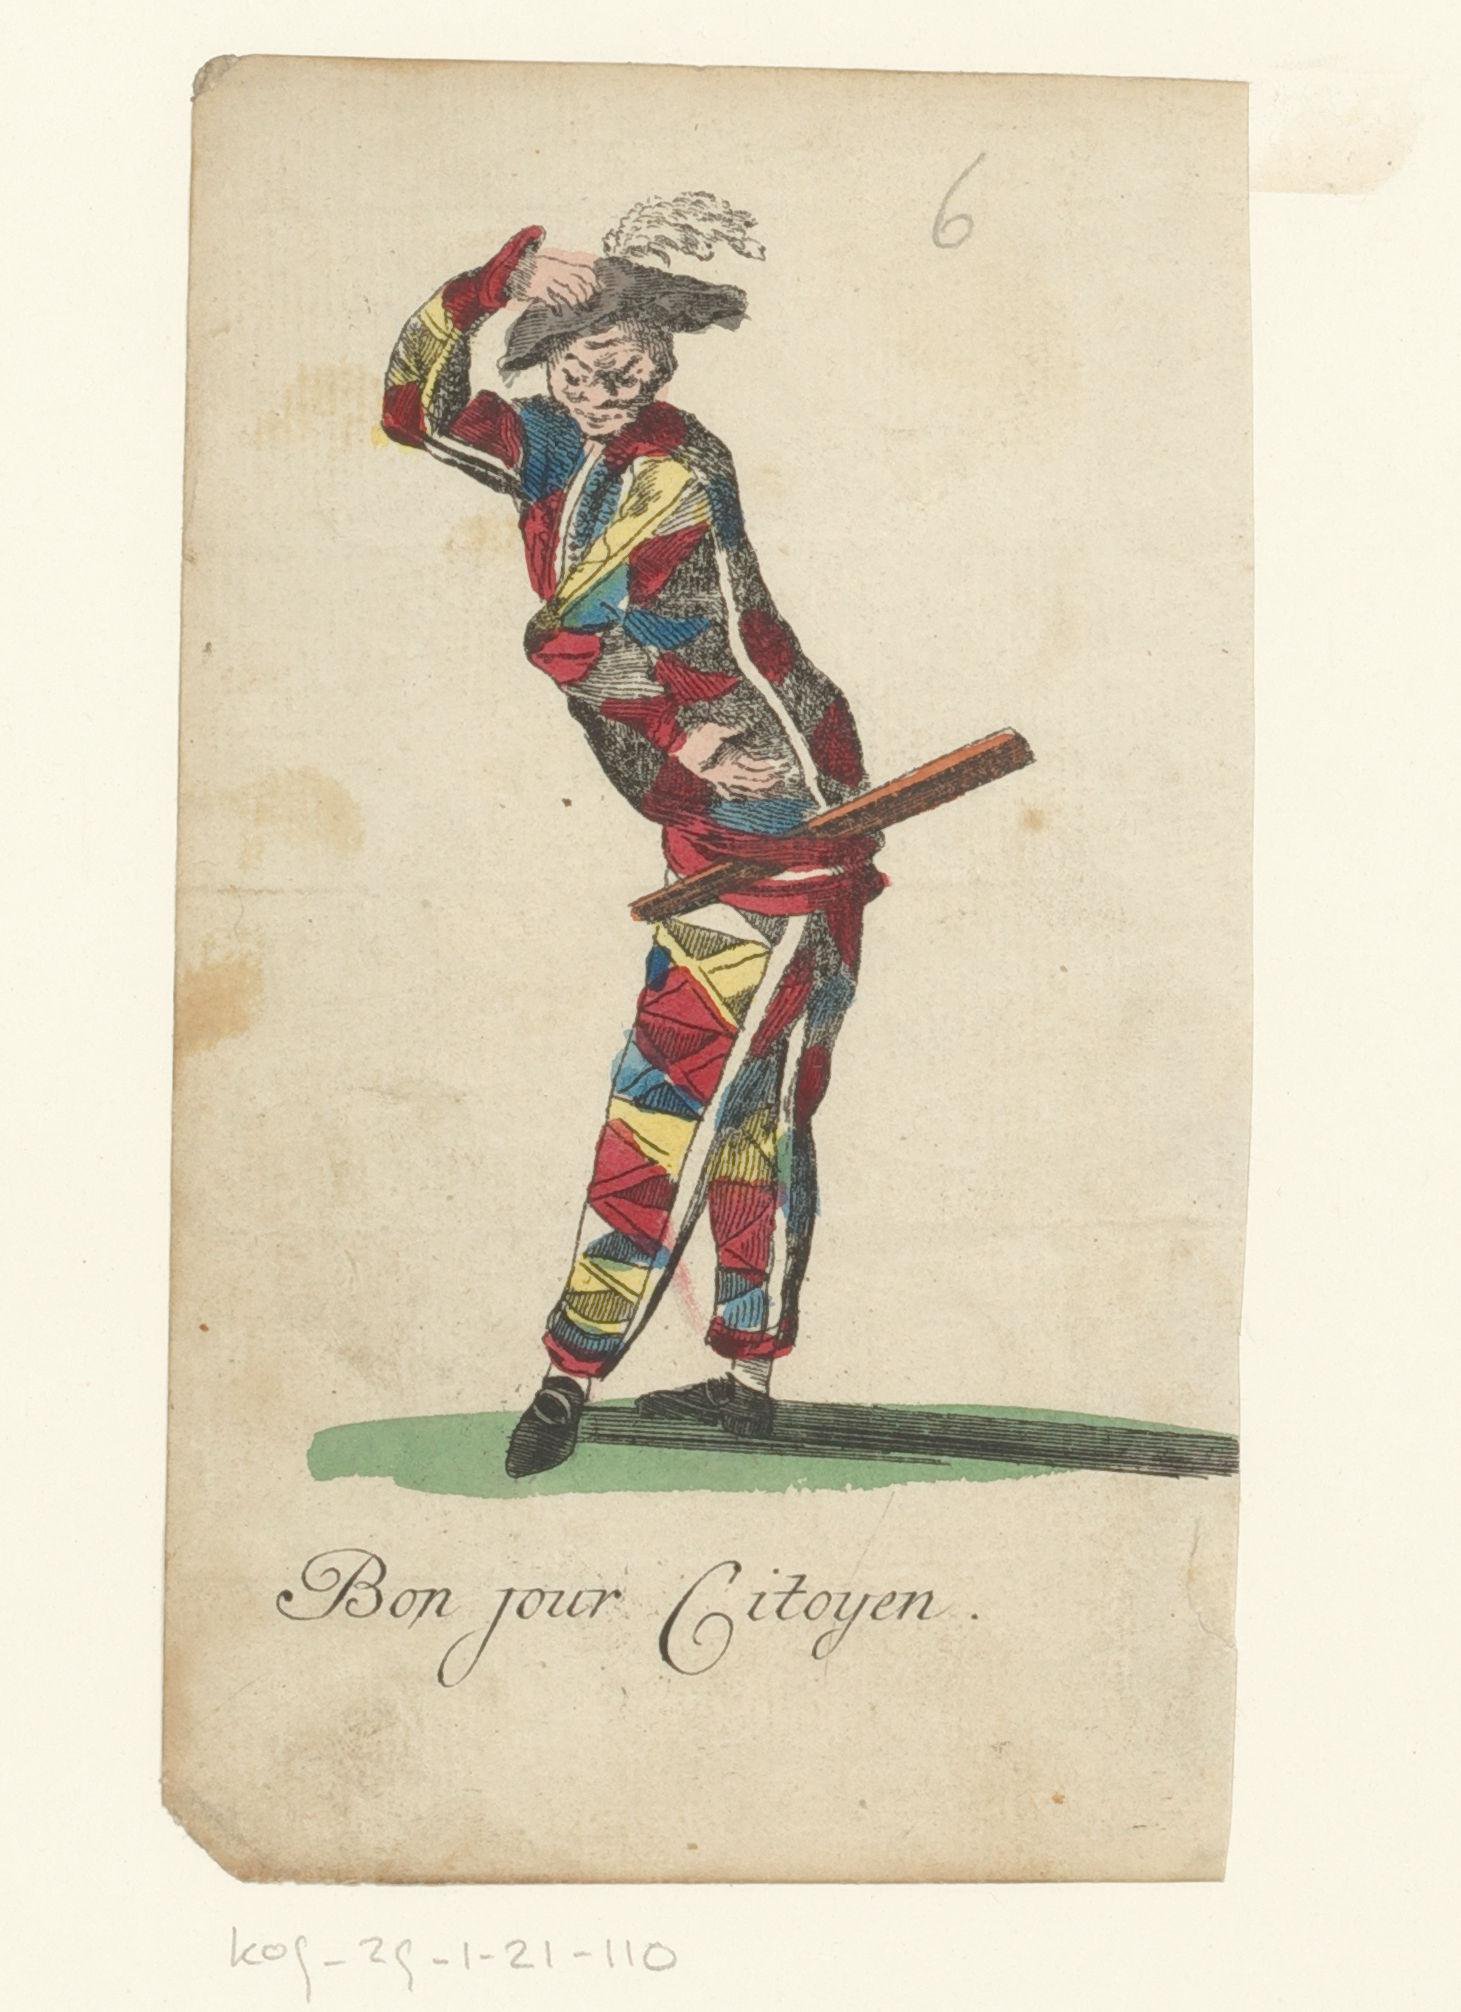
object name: print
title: Bon jour Citoyen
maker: Anonymous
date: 1793-1800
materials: paper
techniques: engraving, etching, hand coloring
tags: acrobat ~ circus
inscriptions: collector's mark: Lugt 1641a, collector's mark: Lugt 1641, stamp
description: Prent waarschijnlijk uit: De vrolijke Zeden-Meester, voor kinderen. Amsterdam: Johannes Roelof Poster, 1800. Of een andere editie van deze uitgave. Volgens de Atlas van Stolk ook gebruikt in: De nieuwe toverlantaarn. Amsterdam: s.n., 1797.